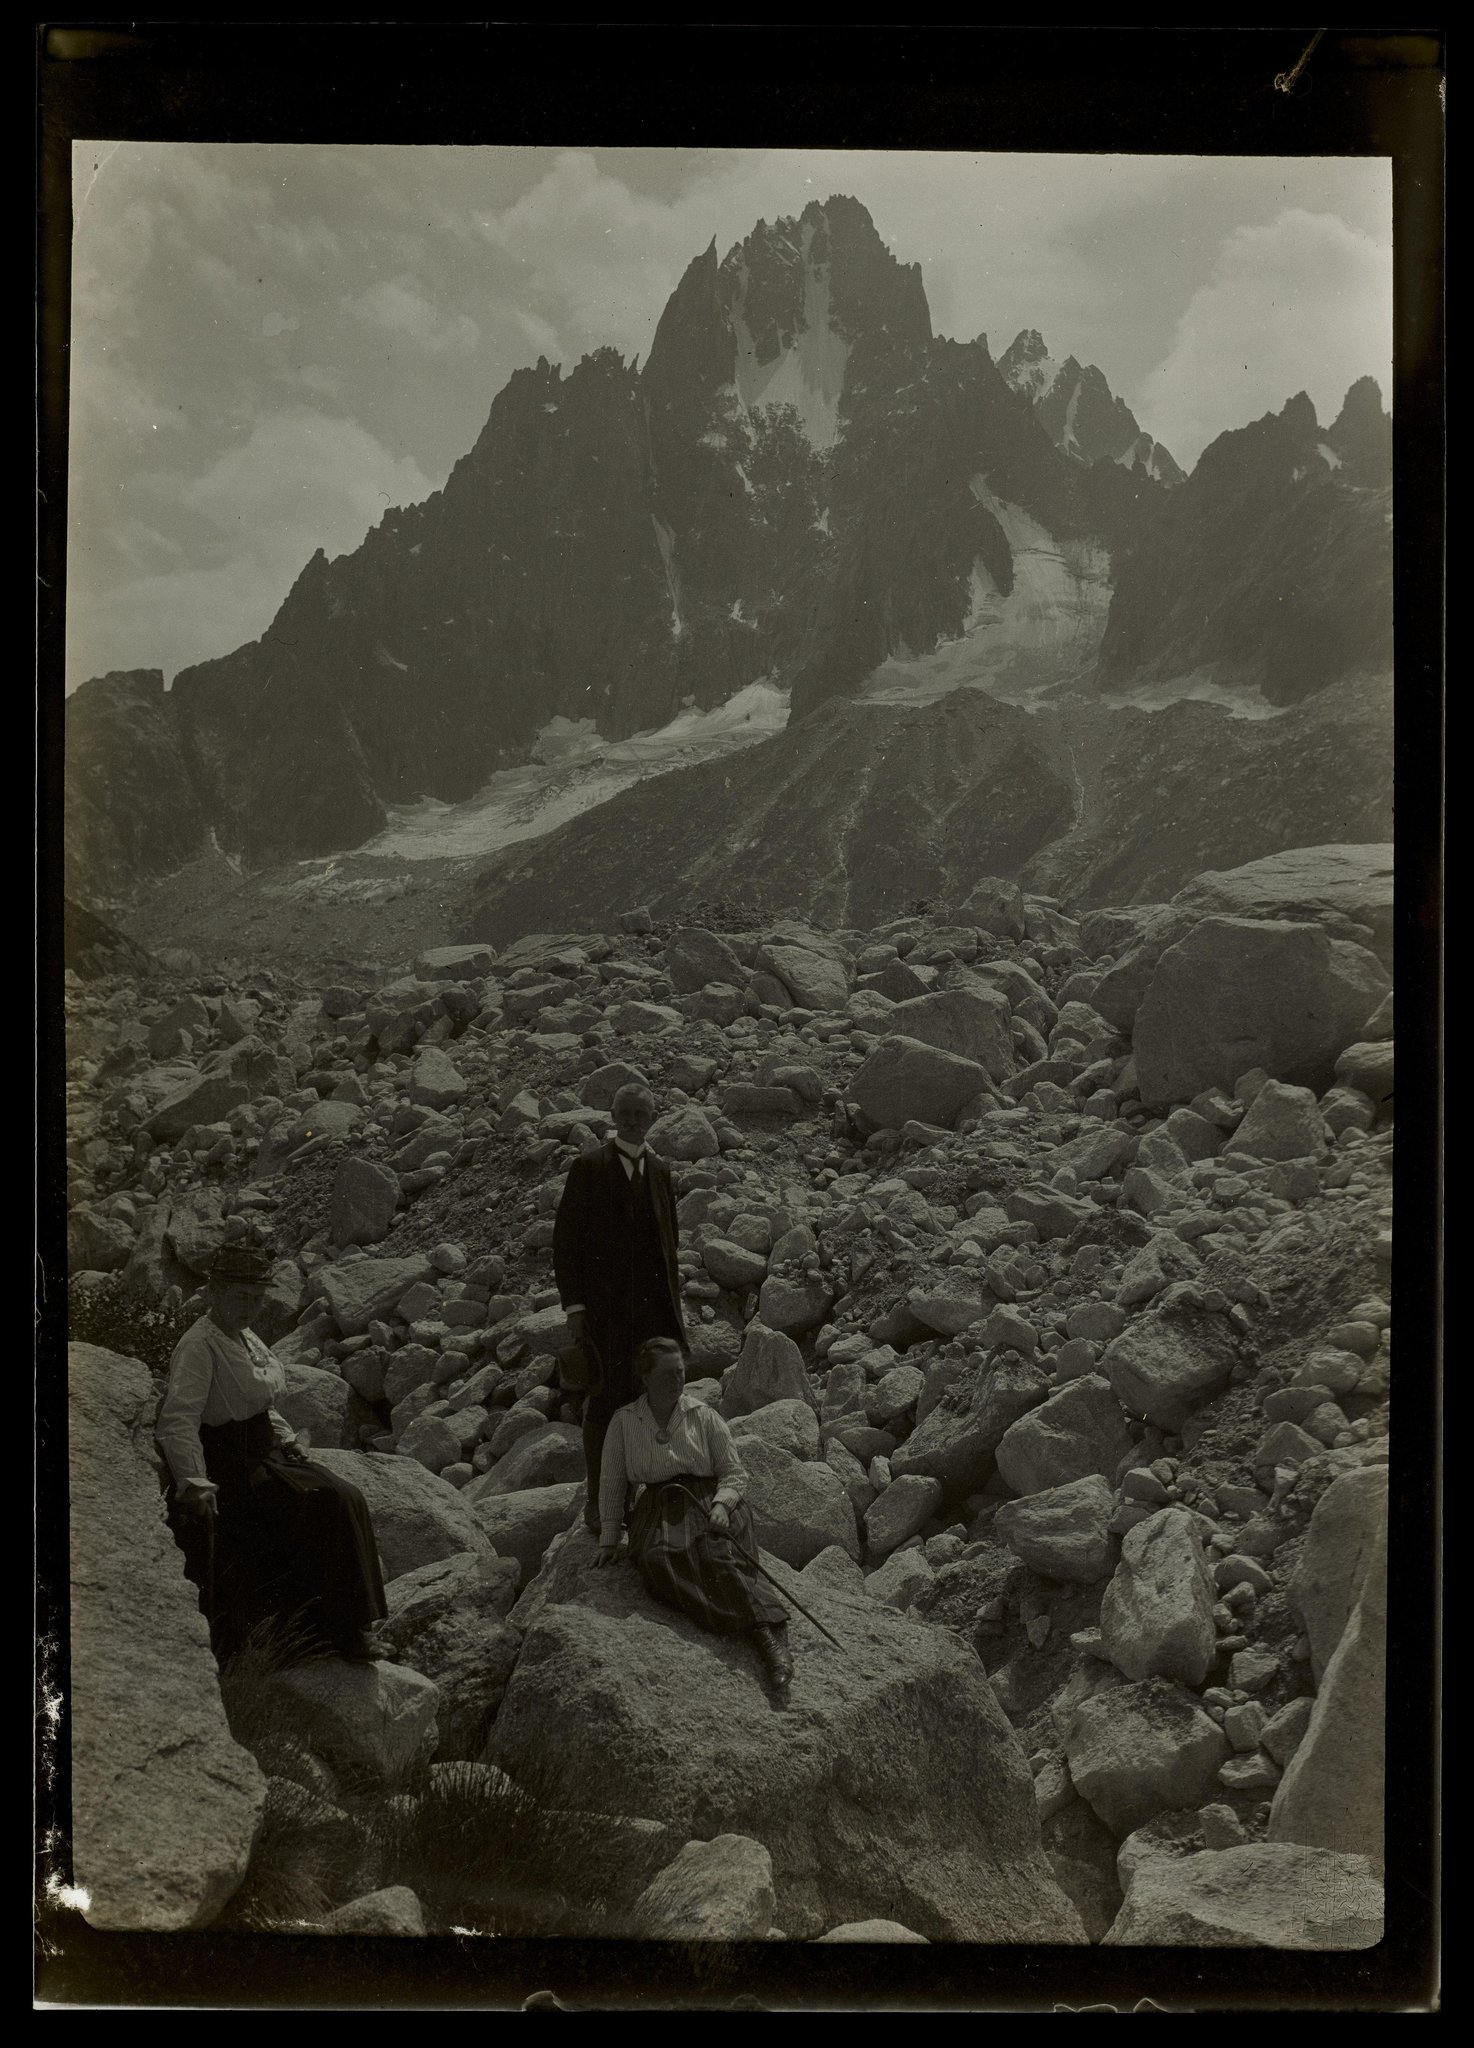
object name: negative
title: Filmnegatief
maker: Anonymous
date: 1907-1935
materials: film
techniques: gelatin silver negative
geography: europe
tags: europe